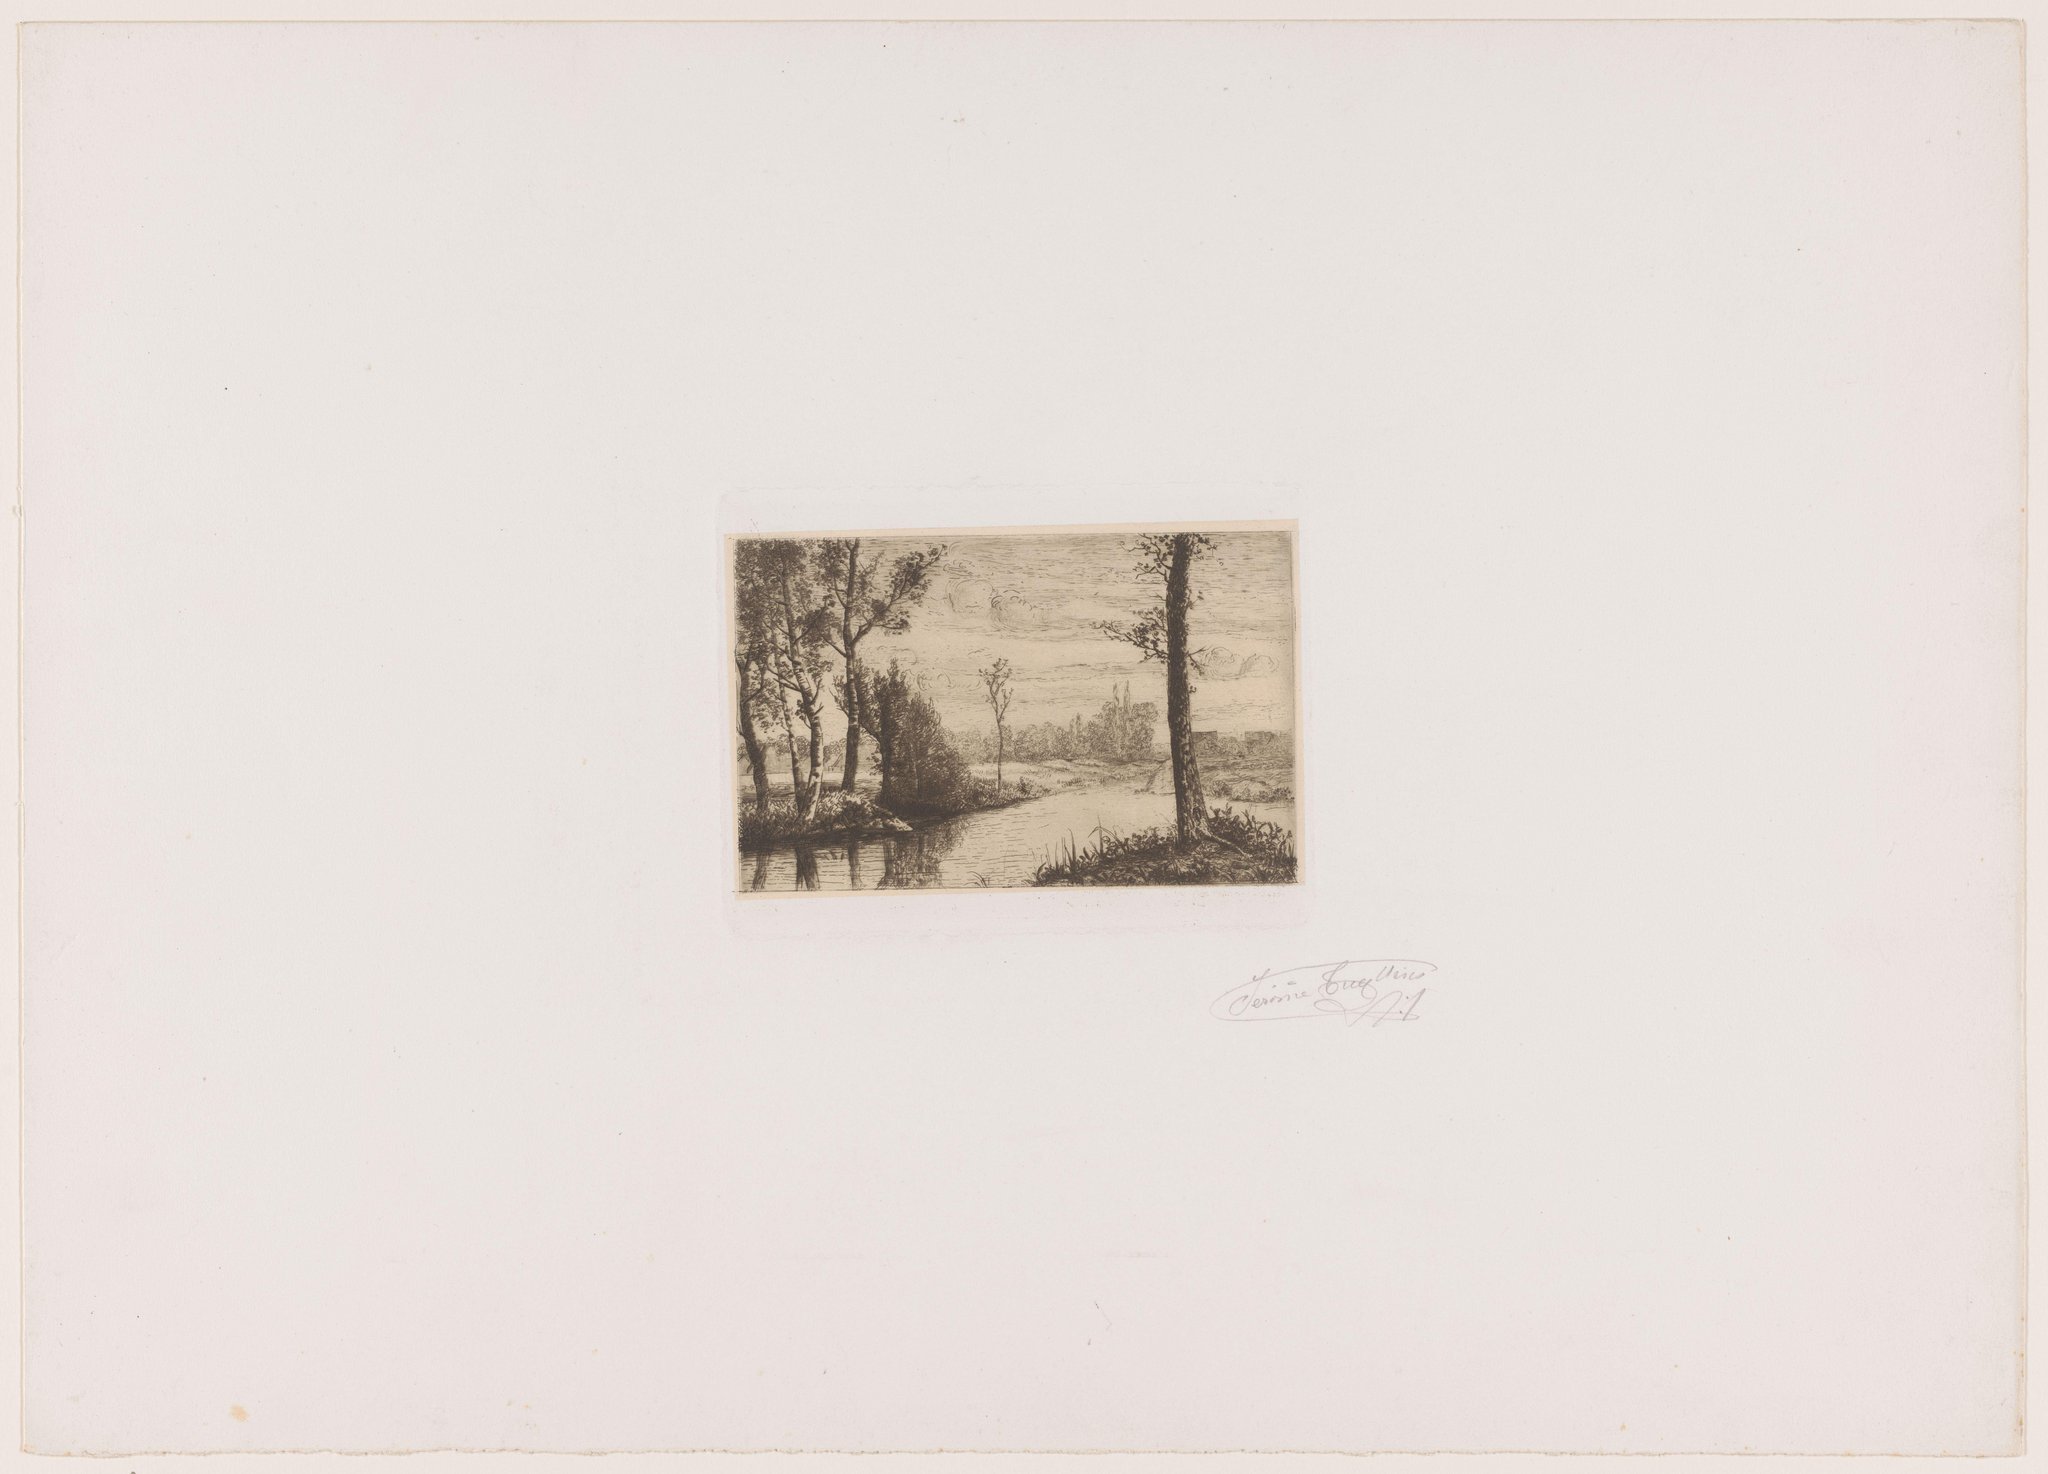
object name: print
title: Landschap met bomen langs een rivier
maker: jerôme tuyttens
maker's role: painter, print maker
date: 1850-1883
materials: paper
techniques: drypoint, etching, intaglio, roulette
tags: water course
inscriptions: collector's mark: Lugt 2228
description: Sterfdatum van de prentmaker is onbekend. Daarom is voor de bepaling van de rechten van dit object gebruik gemaakt van de verwervingsdatum Rijksmuseum Amsterdam.